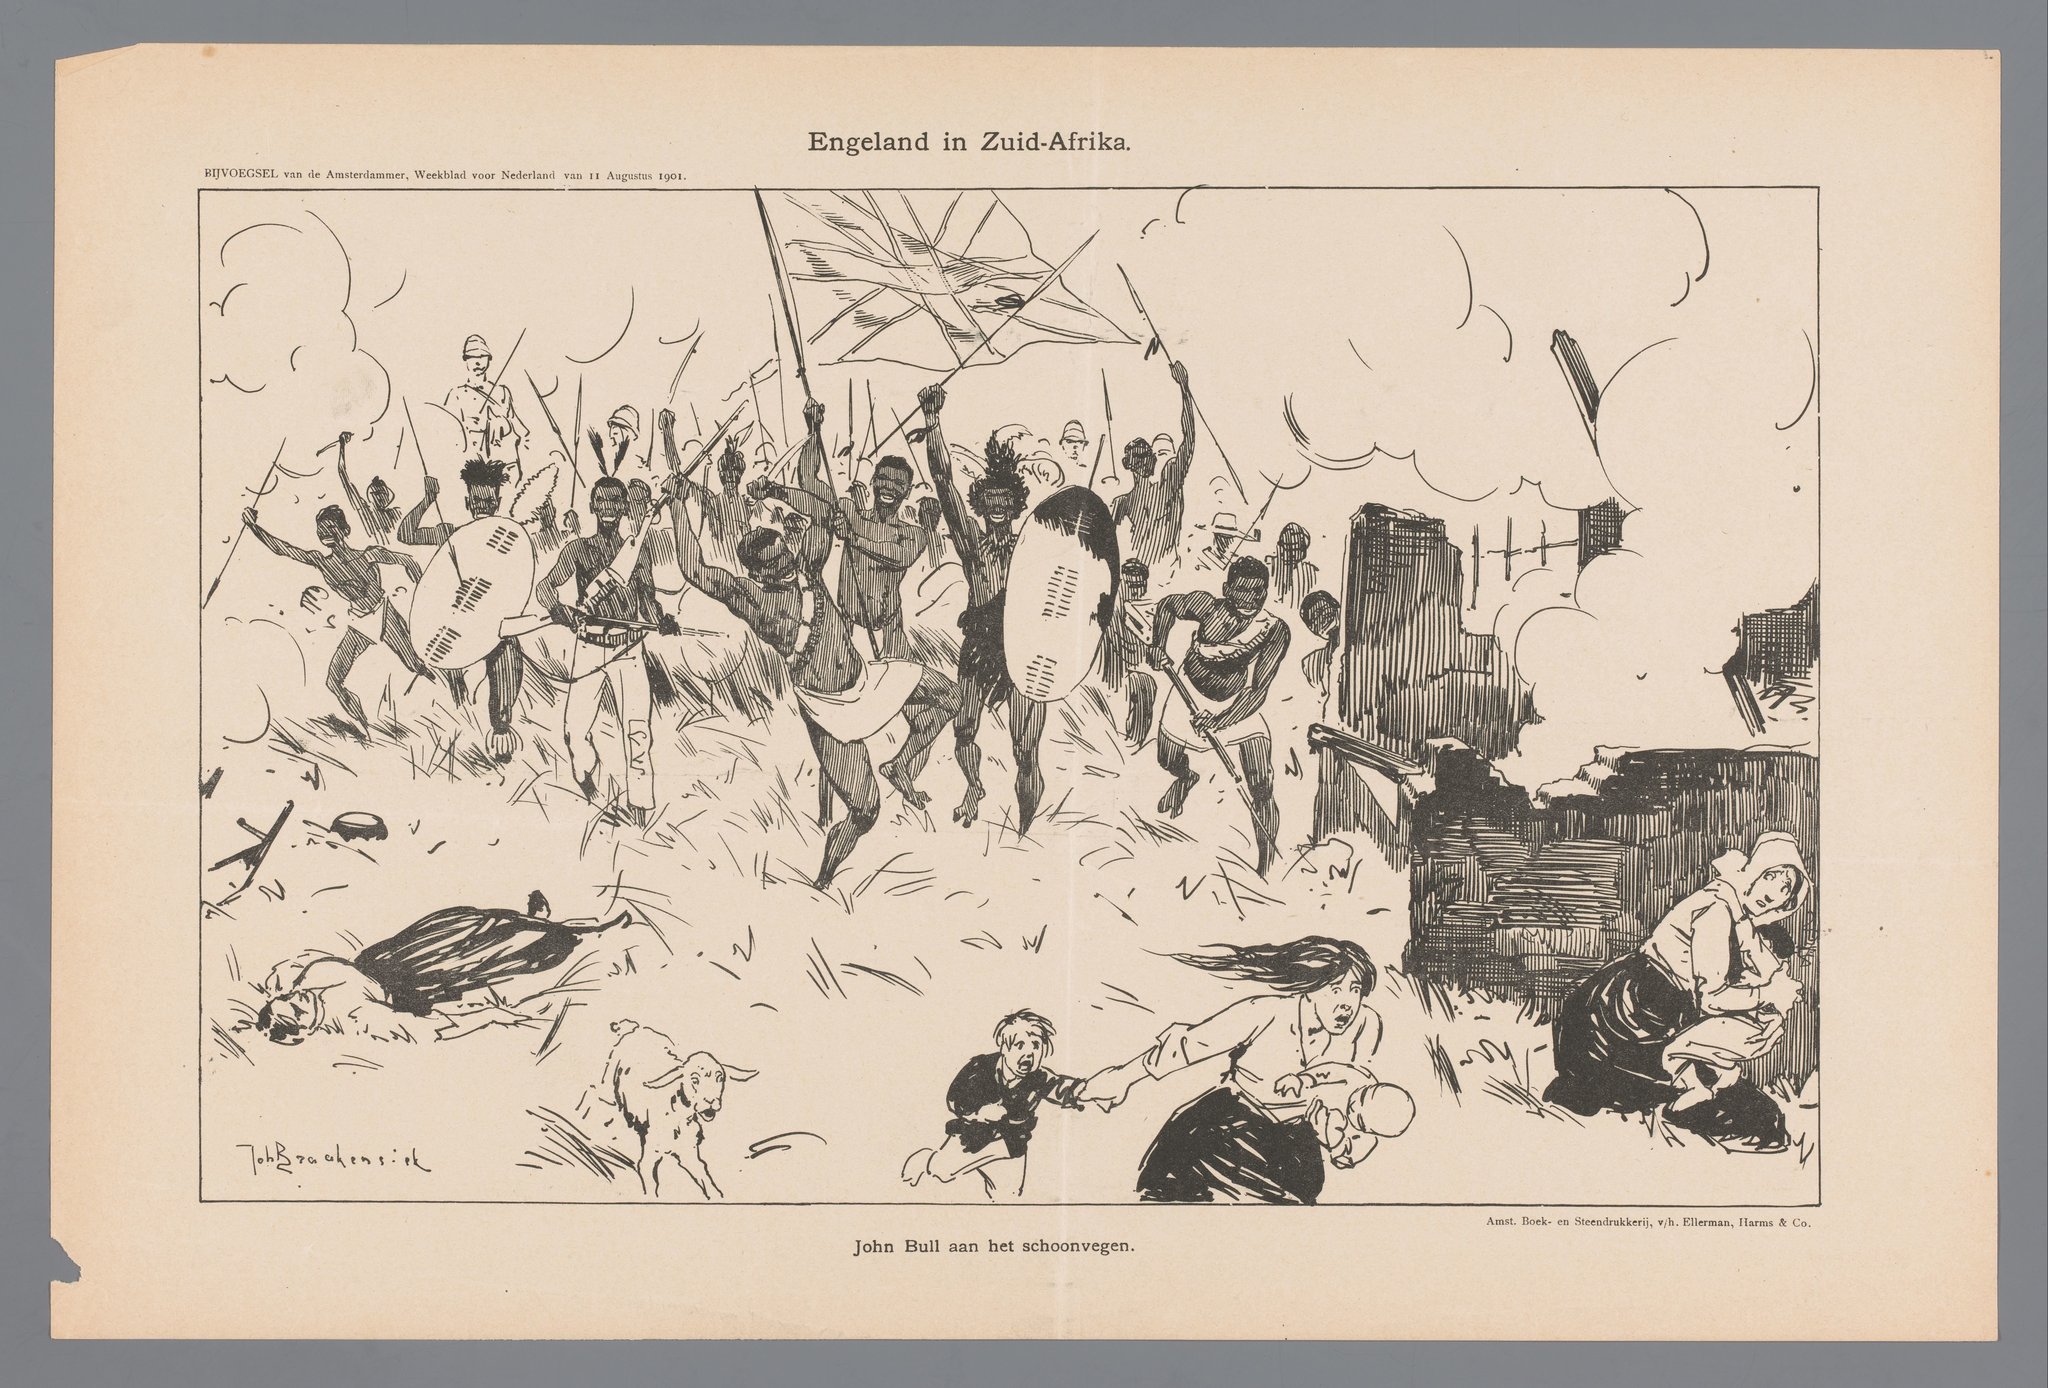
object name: cartoon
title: Engeland in Zuid-Afrika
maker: johan braakensiek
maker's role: draughtsman, print maker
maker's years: 1858-1940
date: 1901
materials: paper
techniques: lithograph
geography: amsterdam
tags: african peoples (zulus), war, political caricatures and satires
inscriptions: date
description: Prent uit het bijvoegsel van: De Amsterdammer. Weekblad voor Nederland, 11 augustus 1901.